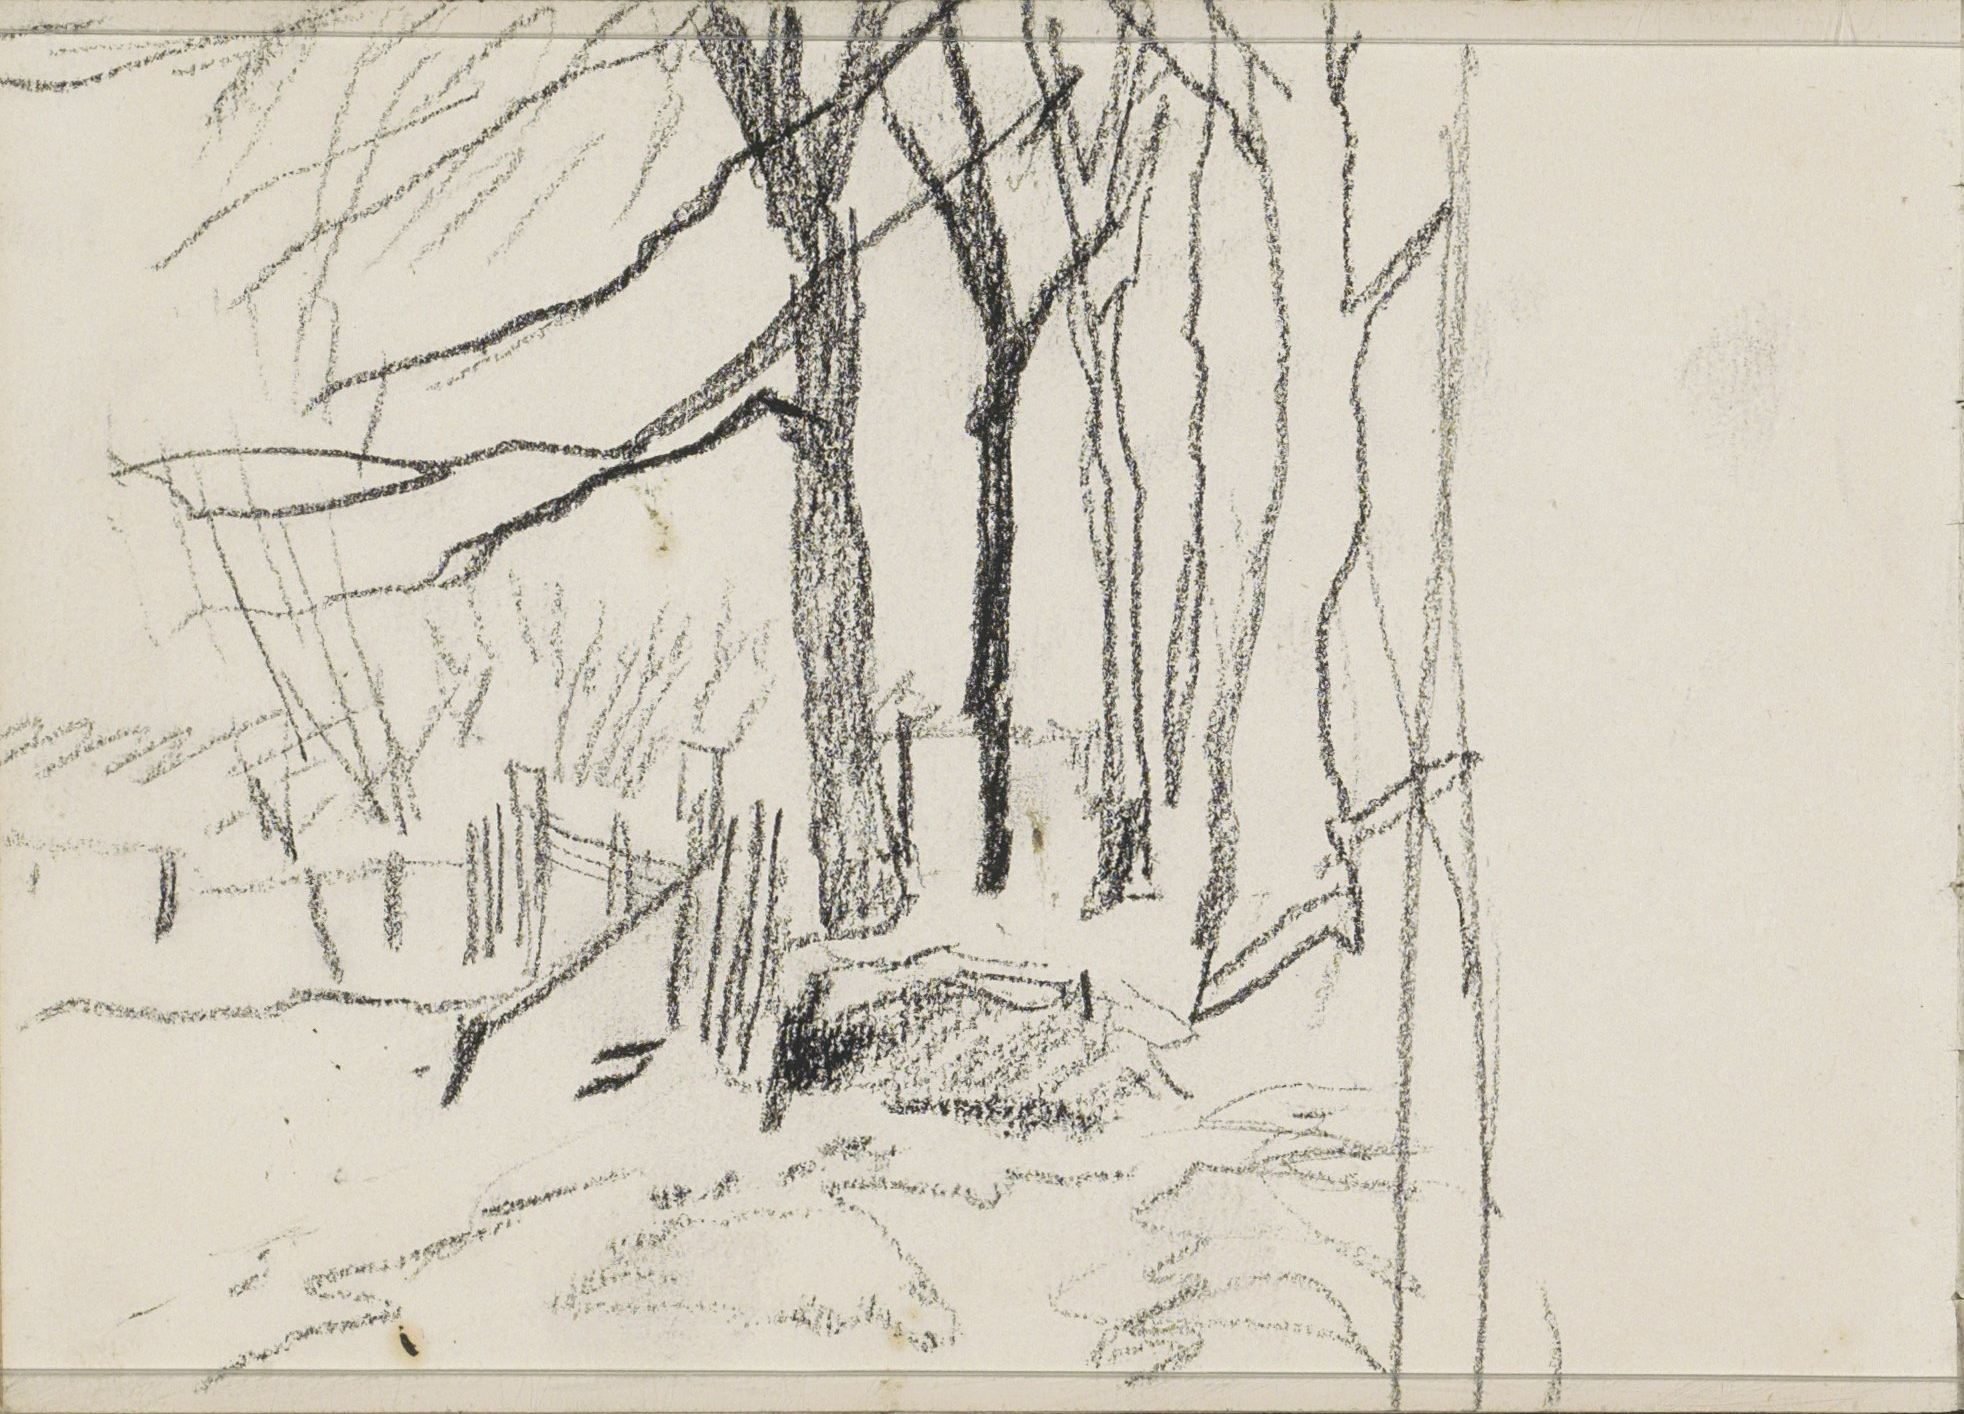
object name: sketchbook leaf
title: Landschap met bomen en een hek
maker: anton mauve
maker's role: draughtsman, painter, print maker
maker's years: 1838-1888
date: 1848-1888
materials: chalk, paper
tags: landscapes, fence, wall, paling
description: Blad 13 verso uit een schetsboek met 31 bladen.